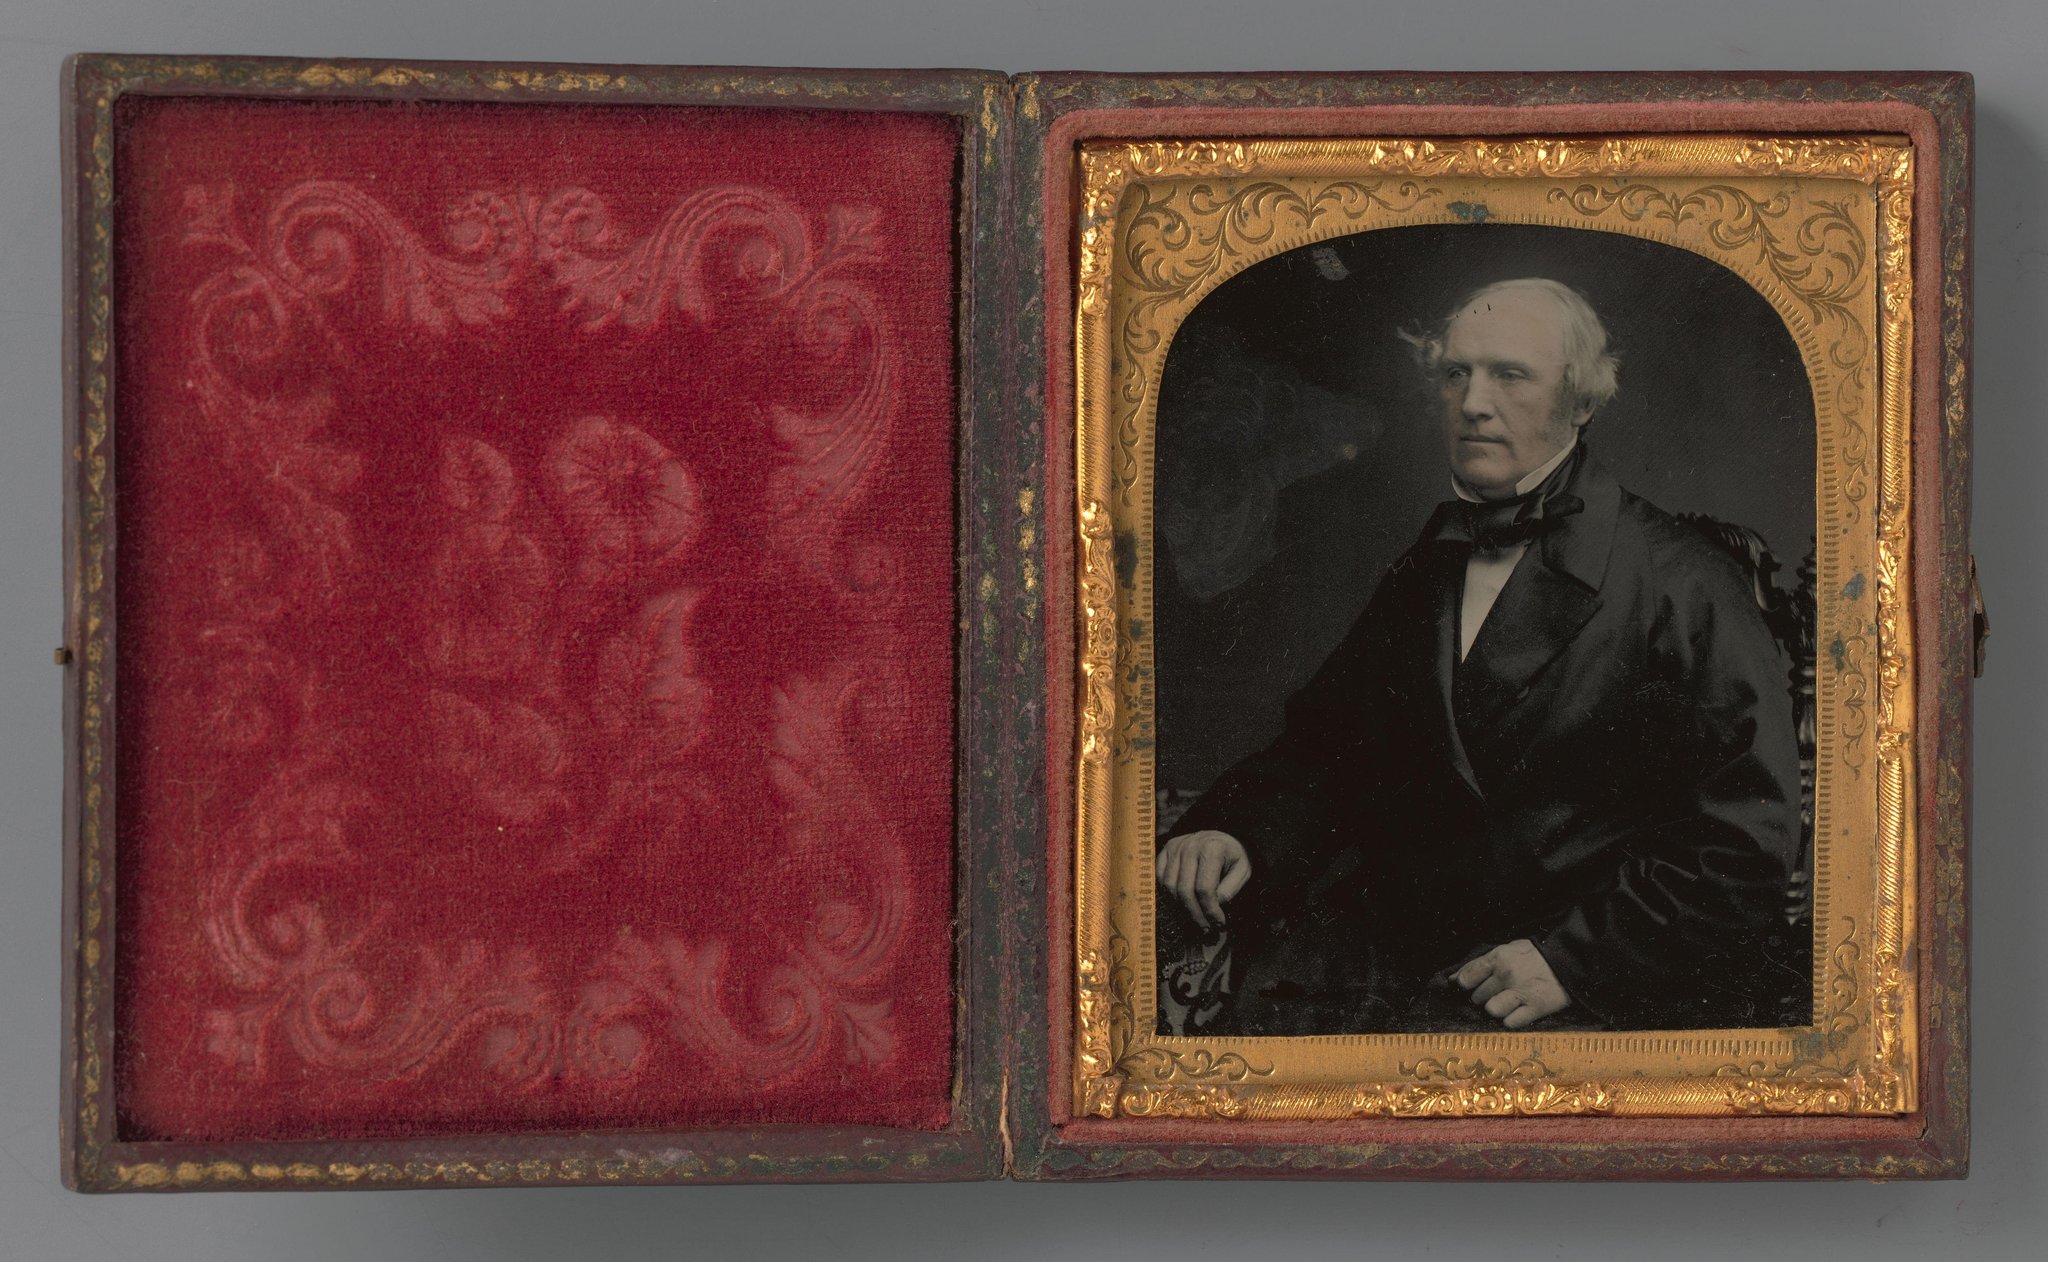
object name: photograph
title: Portret van een onbekende man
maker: Anonymous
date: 1855-1870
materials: glass, metal, velvet, wood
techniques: ambrotype, hand coloring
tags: sitting figure, historical persons, old man